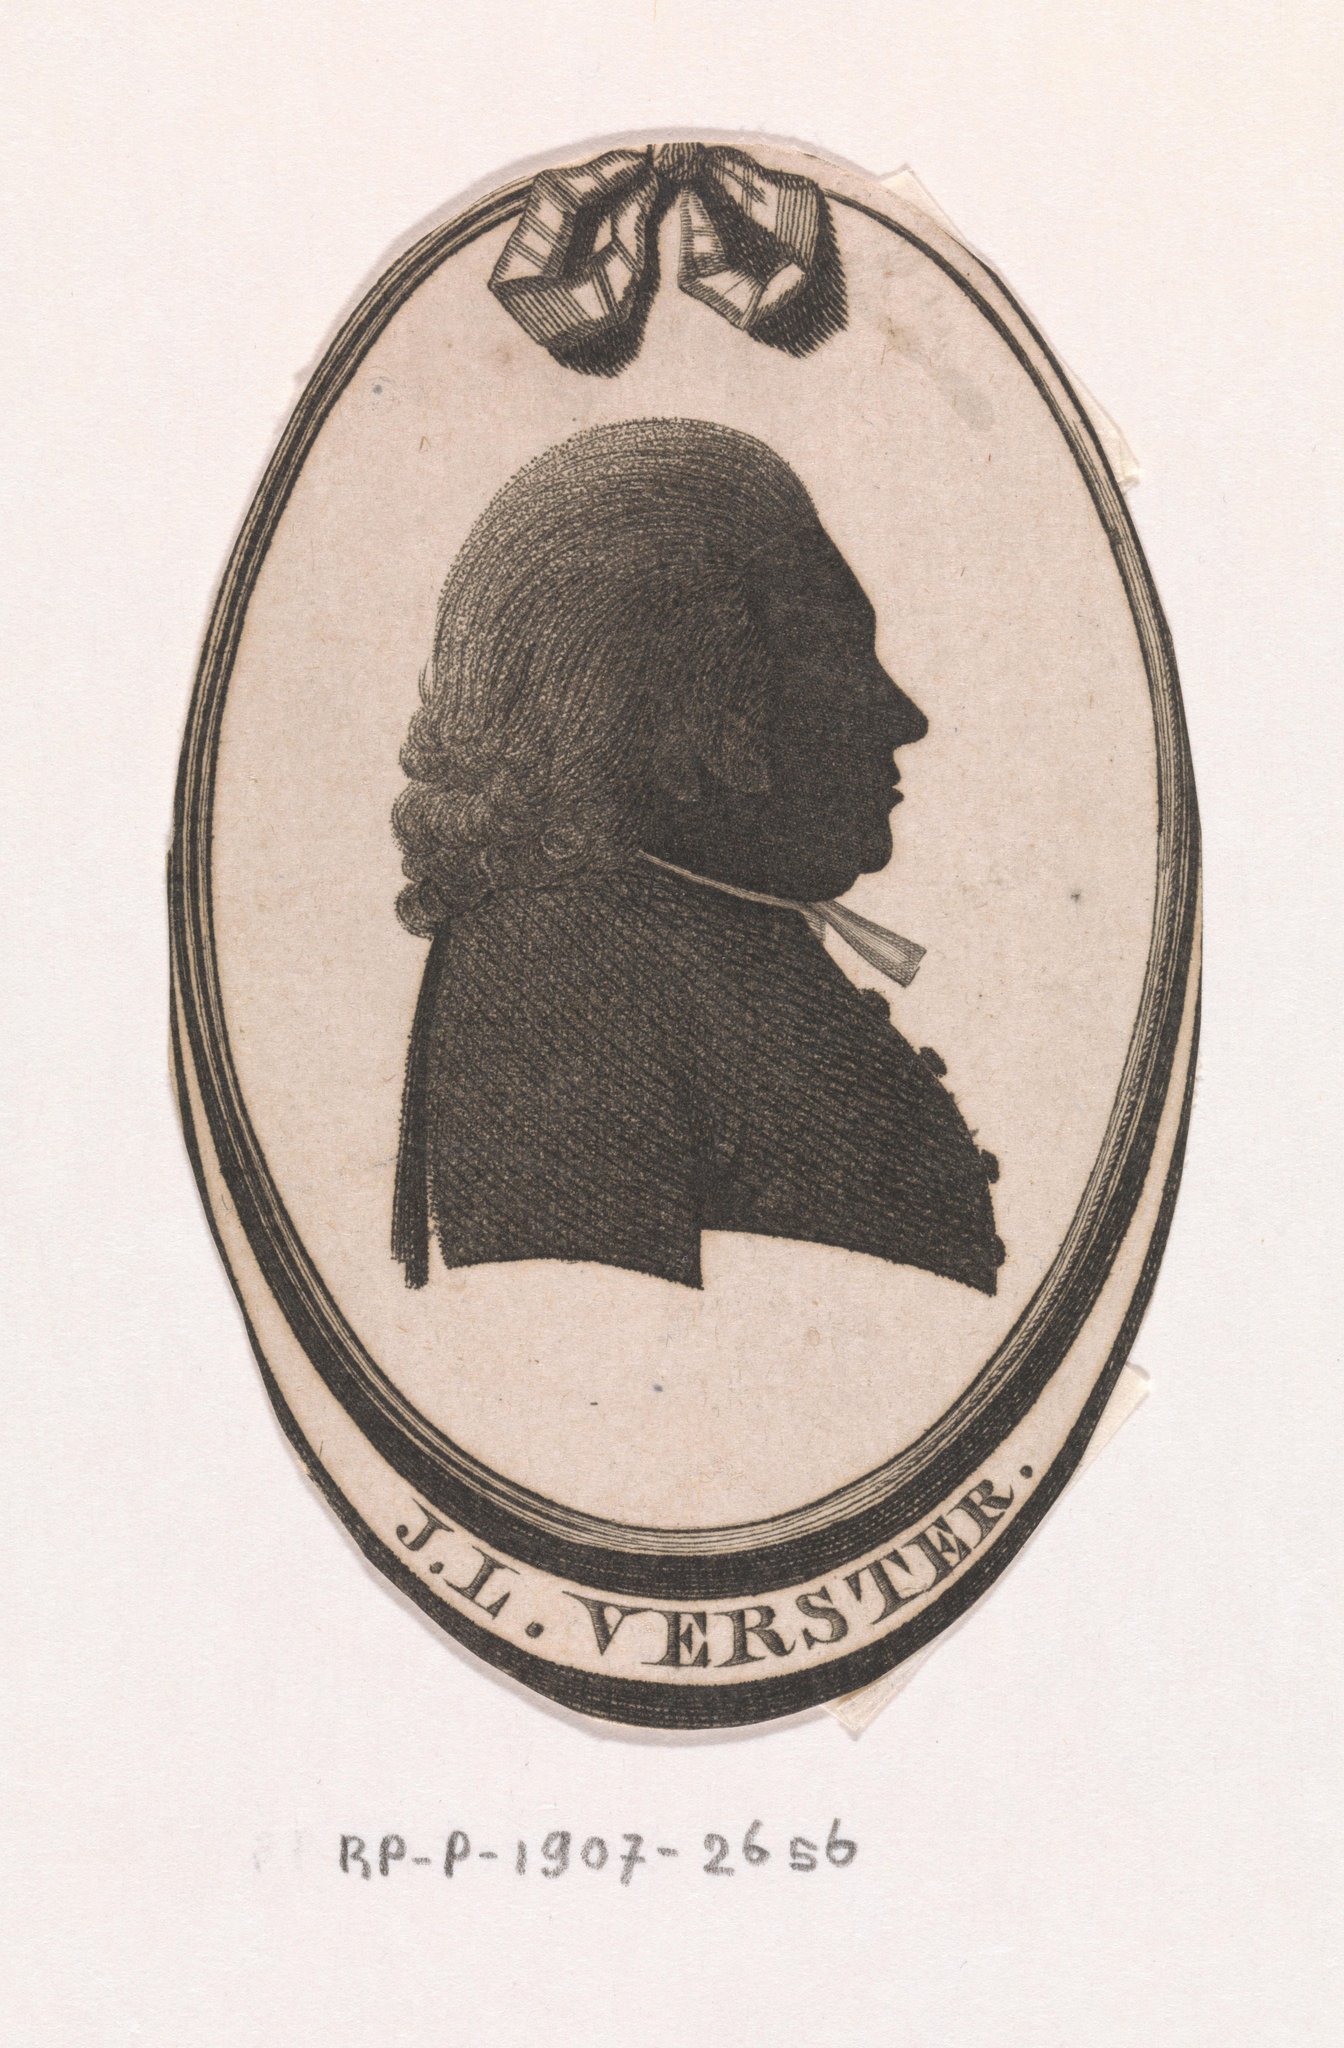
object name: print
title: Silhouetportret van Jean Louis Verster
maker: govert kitsen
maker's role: print maker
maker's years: 1766-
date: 1776-1810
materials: paper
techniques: engraving, etching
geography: rotterdam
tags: den bosch, rotterdam, wig (+ sideview, profile)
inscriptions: collector's mark: Lugt 2228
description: Portret van Jean Louis Verster, predikant te Zuilen, Wageningen, Dordrecht en Rotterdam. Hij draagt een batterijpruik en bef. Buste in profiel in ovale lijst met strik bovenaan.